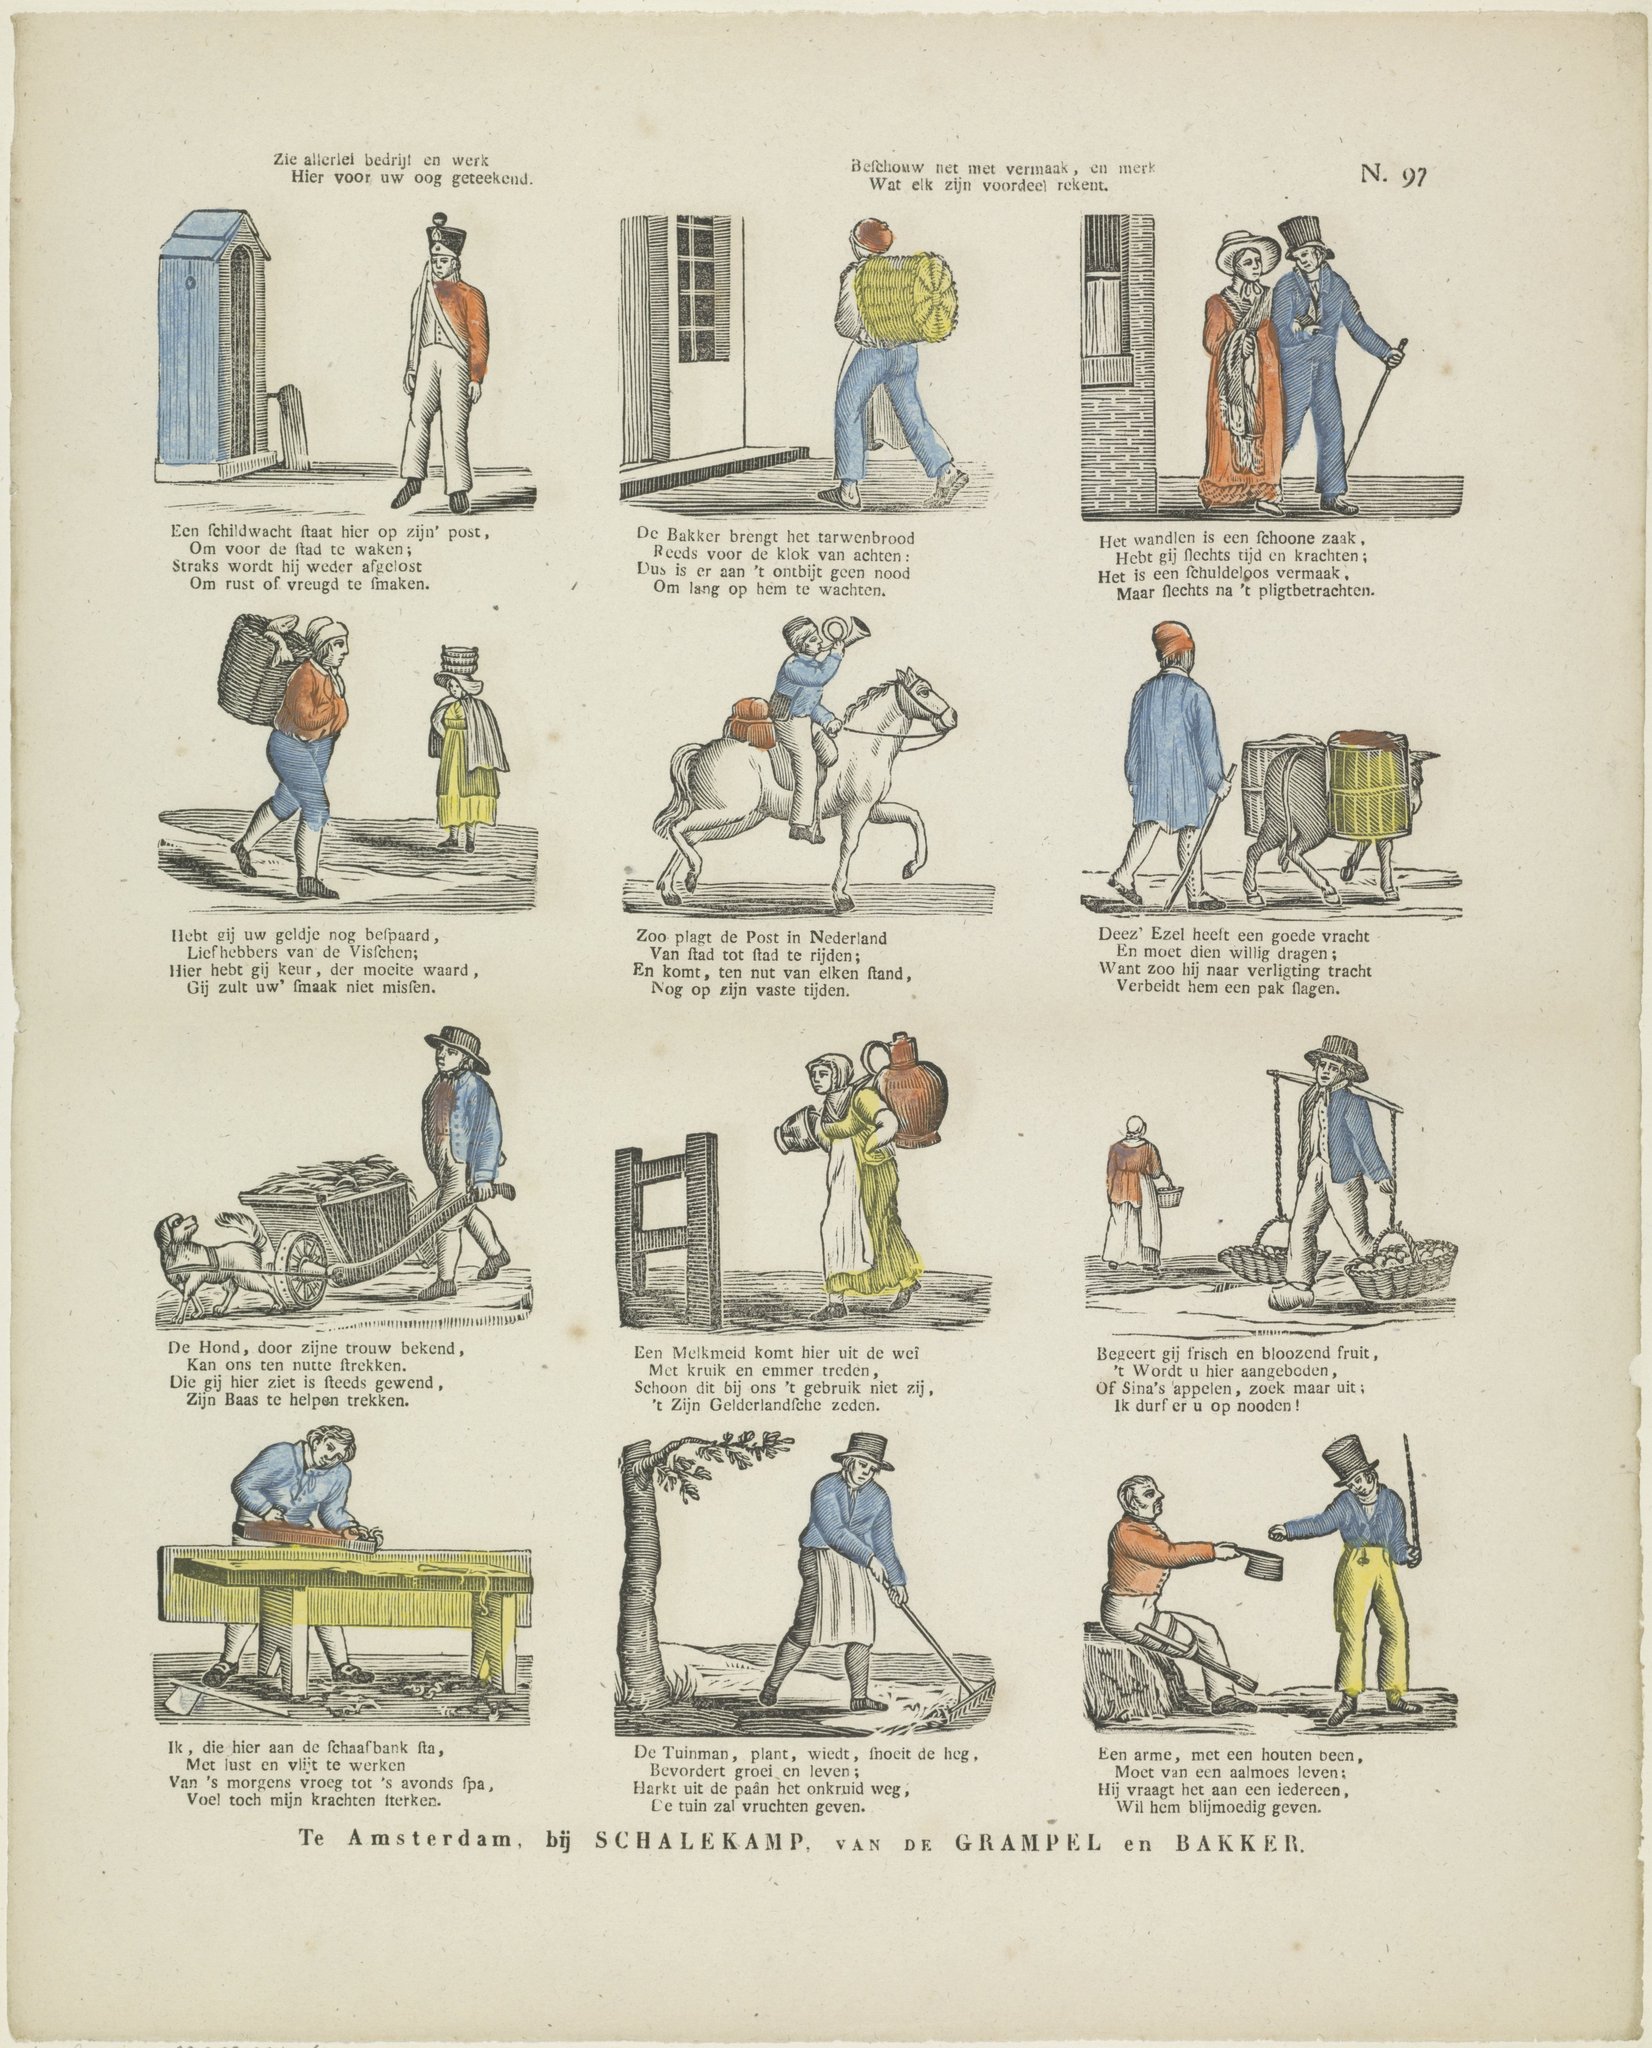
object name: popular print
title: Zie allerlei bedrijf en werk / Hier voor uw oog geteekend. / Beschouw het met vermaak, en merk / Wat elk zijn voordeel rekent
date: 1822-1849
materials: paper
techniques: colour, letterpress printing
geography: amsterdam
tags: craft-production, skilled handiwork, street-trader, baker, crafts and industries, guard duty, keeping sentry, merchant, salesman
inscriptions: collector's mark: Lugt 2760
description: Blad met 12 voorstellingen van ambachtslieden en beroepen, zoals schildwacht, bakker en tuinman. Onder elke afbeelding een vierregelig vers. Genummerd rechtsboven: N. 97.